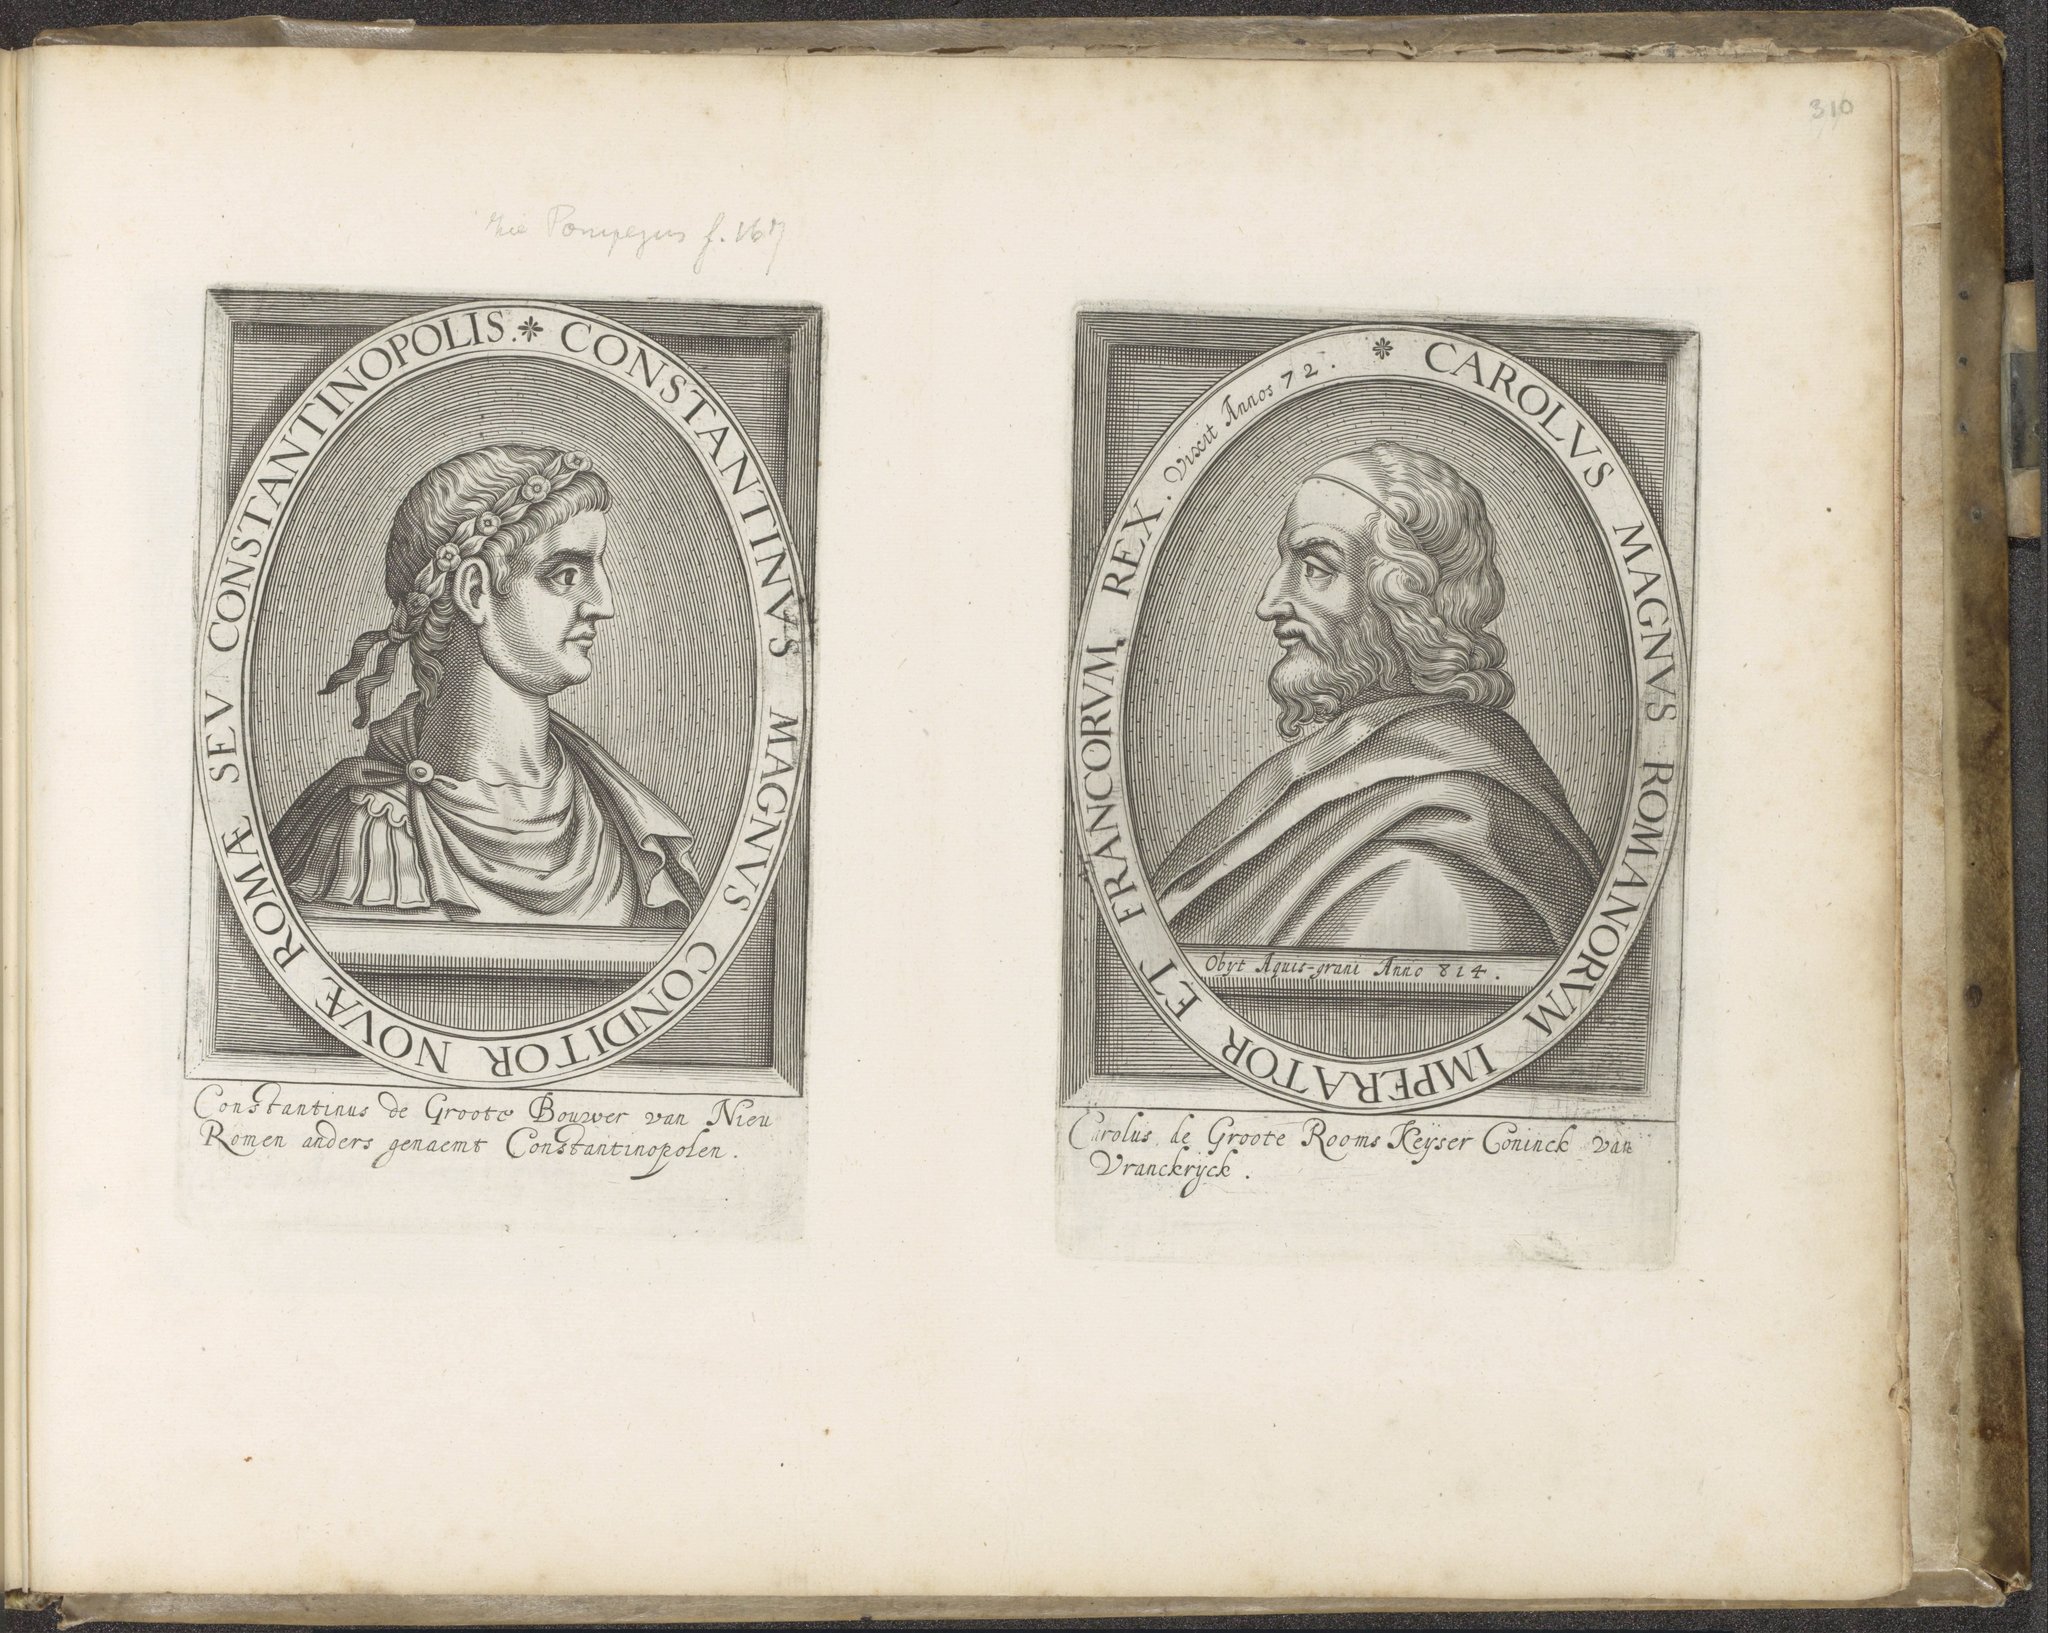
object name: album leaf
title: Den Grooten Emblemata Sacra, bestaande in meer dan vier hondert bybelsche figuren, zoo des Ouden als des Nieuwen Testaments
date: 1610-1625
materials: paper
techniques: engraving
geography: amsterdam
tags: charlemagne (holy roman emperor)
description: Beide portretten werden oorspronkelijk uitgegeven door Nicolaes de Clerck in de periode 1610-1625.